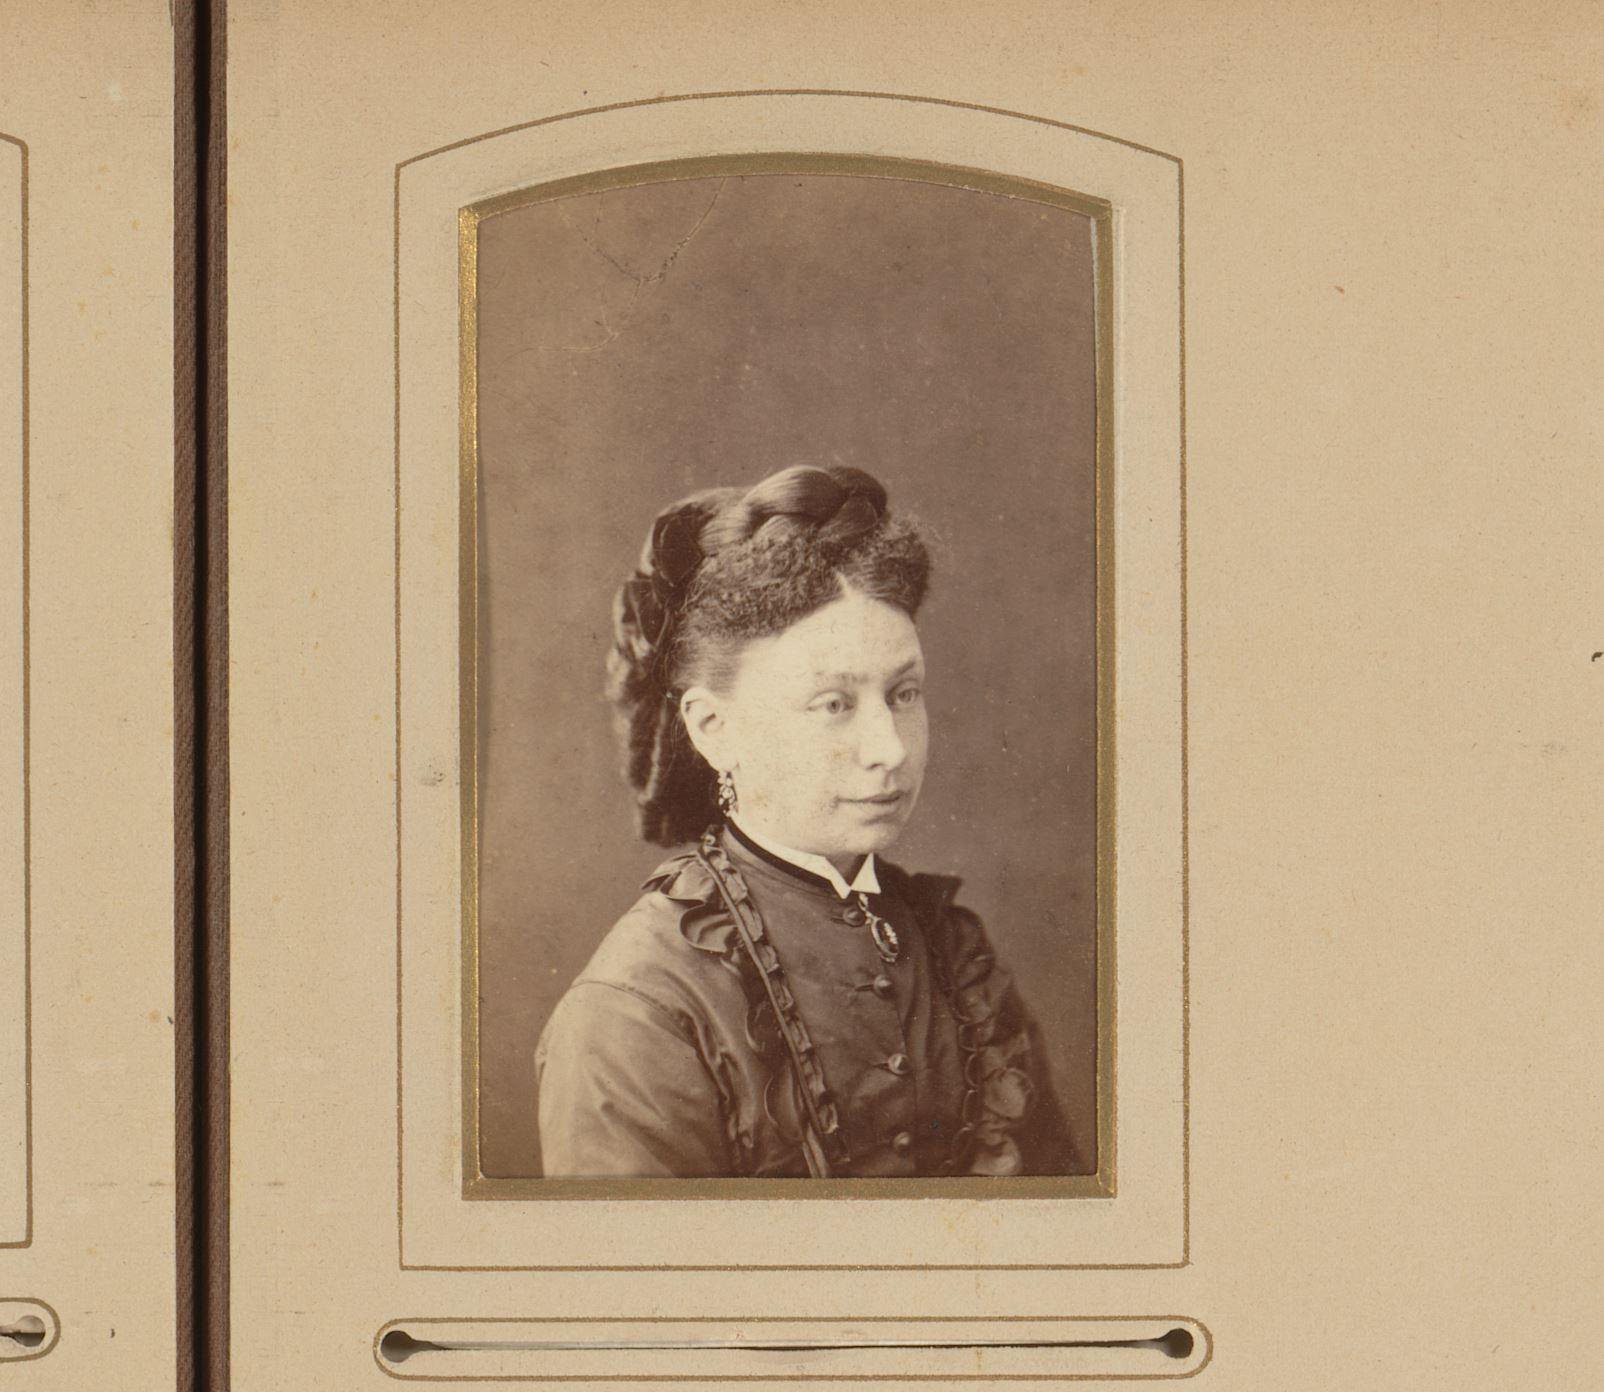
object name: photograph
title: Portret van een rouw met gevlochten haren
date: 1856-1876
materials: cardboard, photographic support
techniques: albumen print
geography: leuven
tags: historical persons - bb - woman, hairdress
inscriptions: inscription: ‘PHOTOGRAPHIE/ DE/ Chs. Verbeke Schodts/ 20, Rue de Bruxelles/ LOUVAIN/ Le Cliché étant conservé, il suffit de/ rappeler le nom pout obtenir des mêmes/ Cartes.’